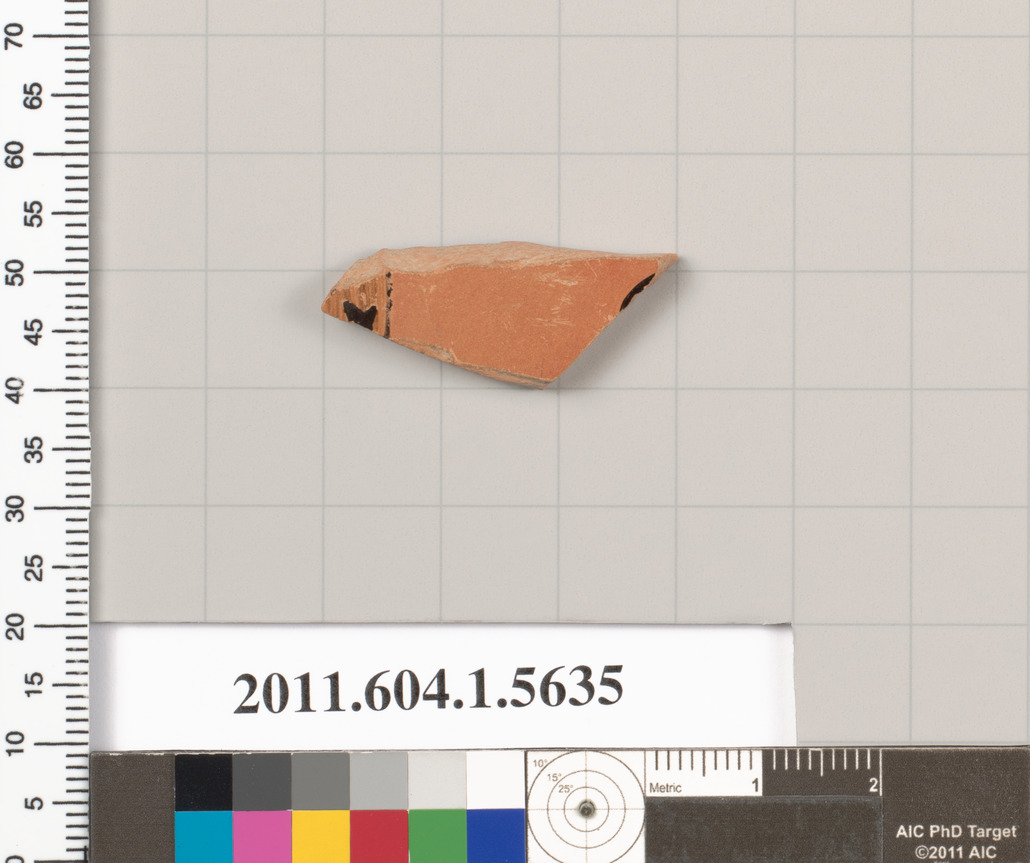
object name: kylix fragment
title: Terracotta fragment of a kylix (drinking cup)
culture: greek, attic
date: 510-490 BCE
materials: terracotta